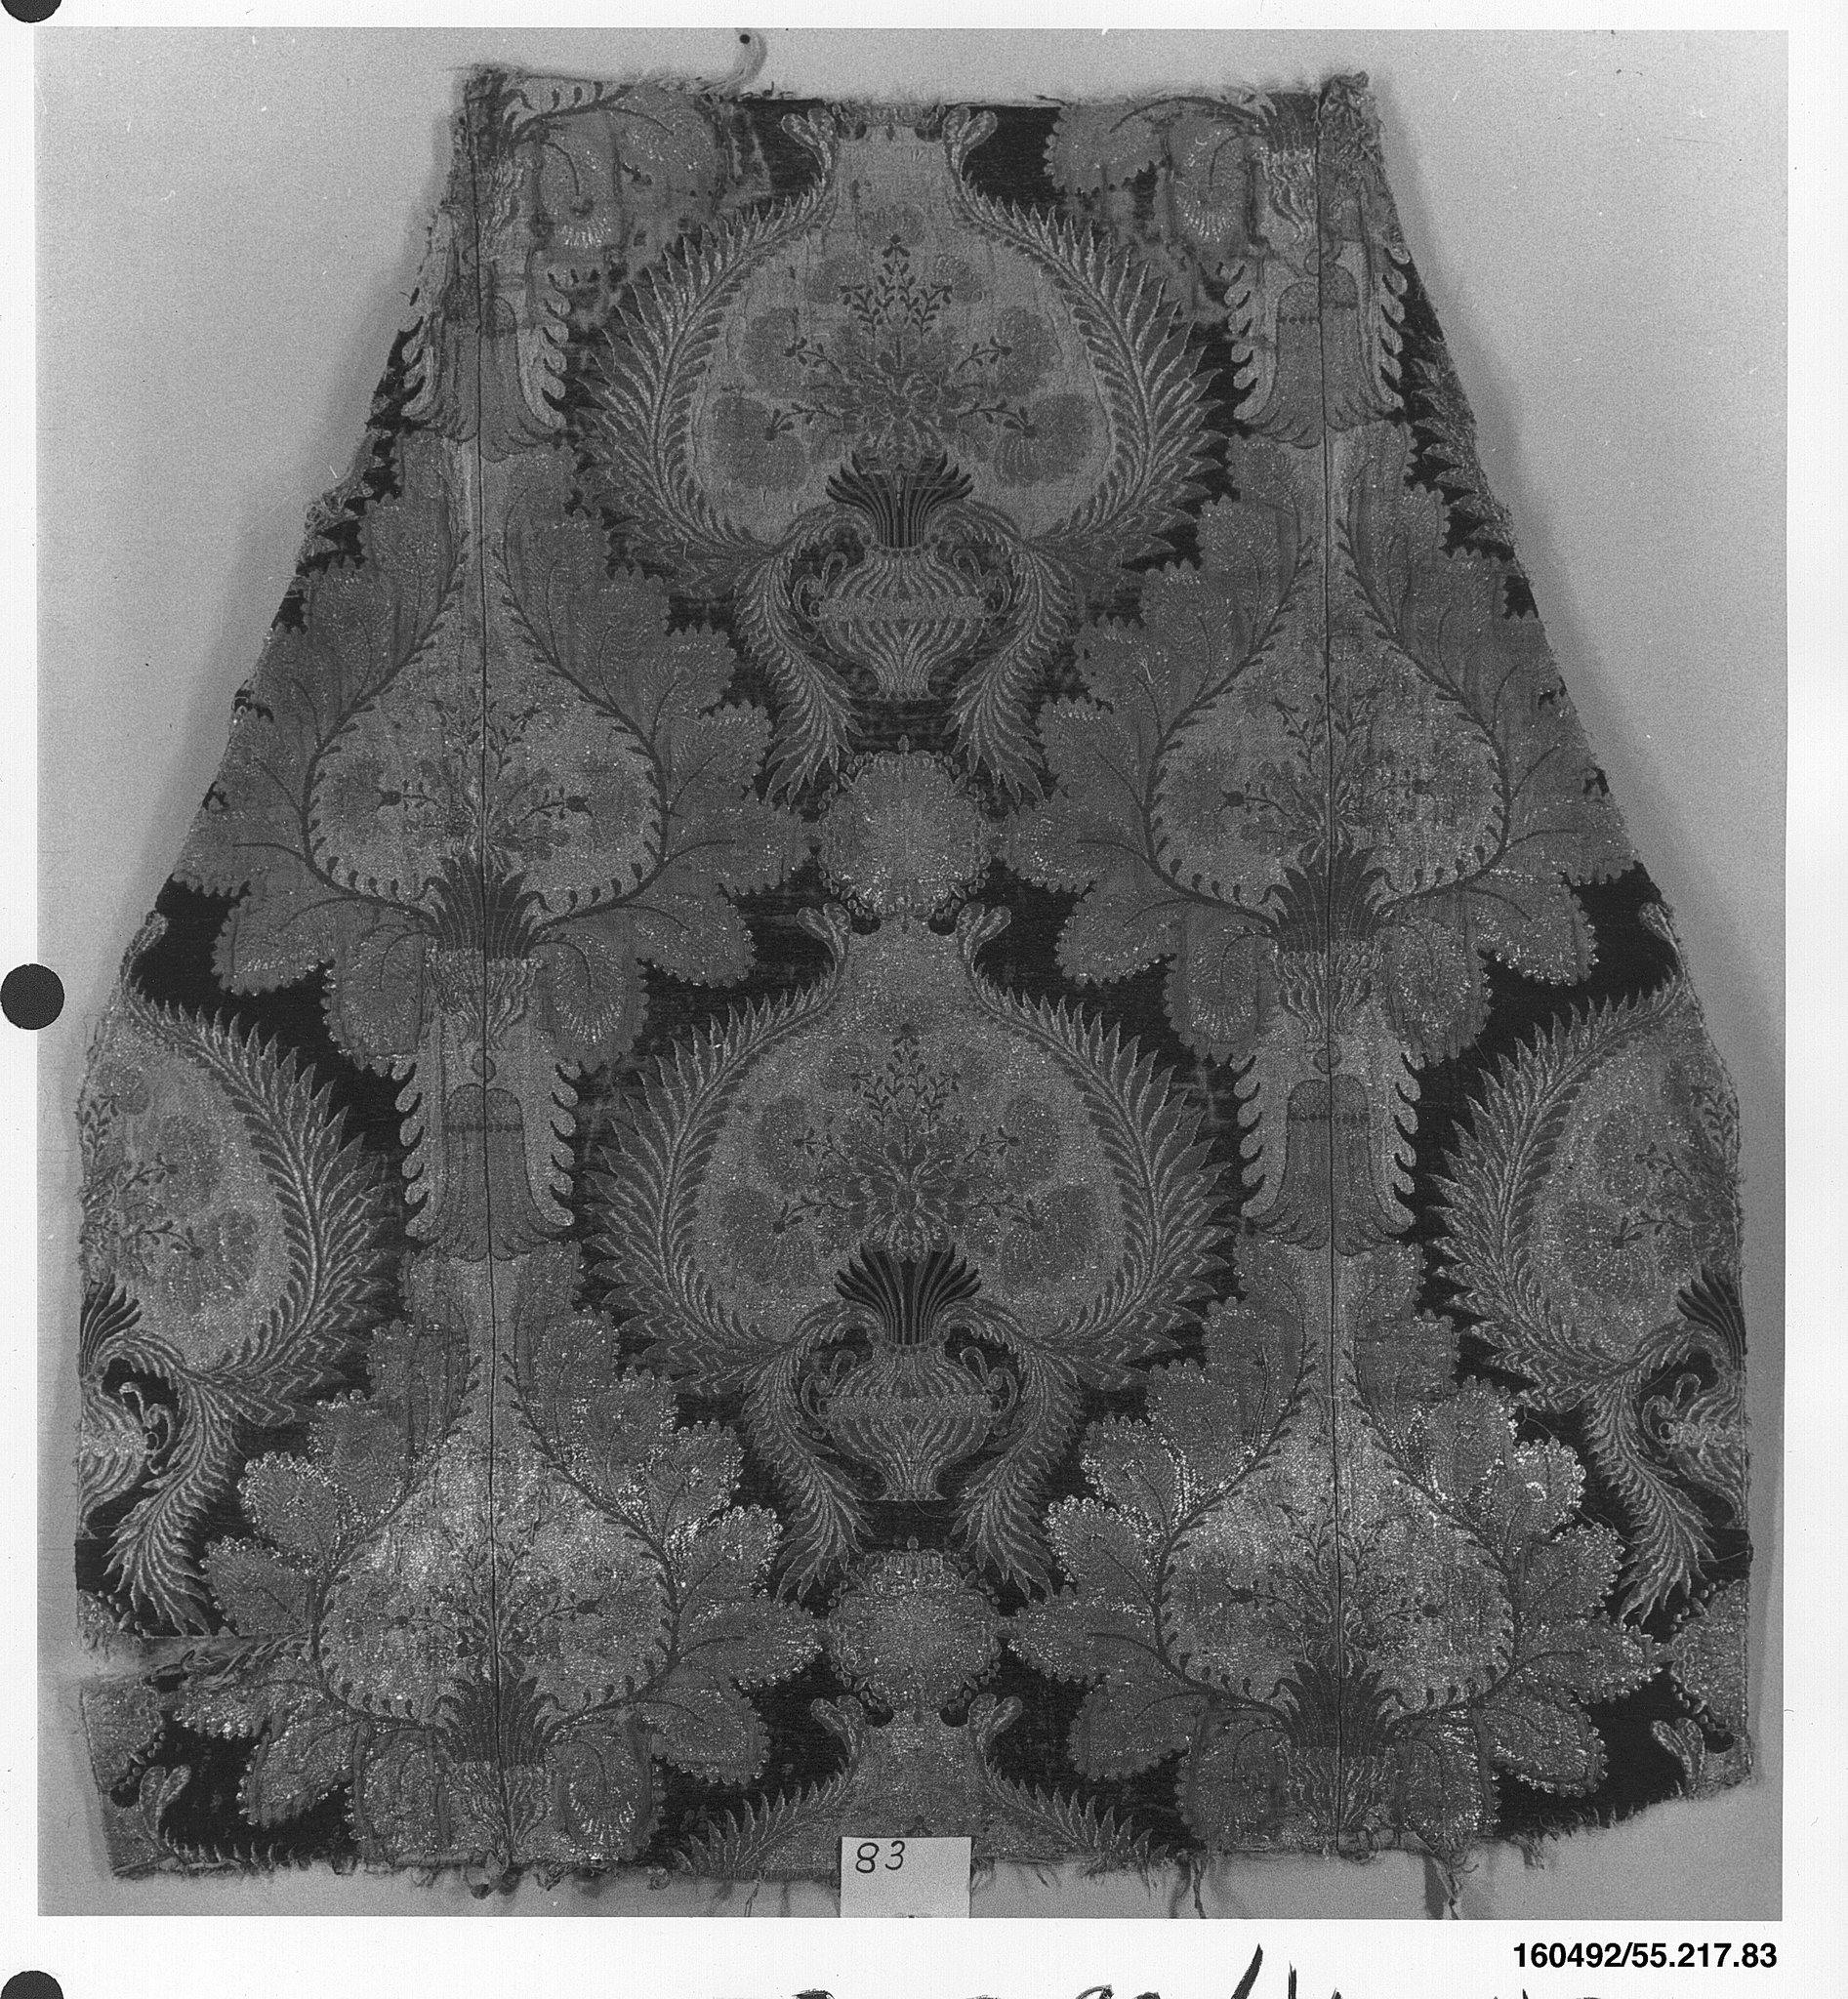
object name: piece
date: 1701-1900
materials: cotton, metal thread, silk